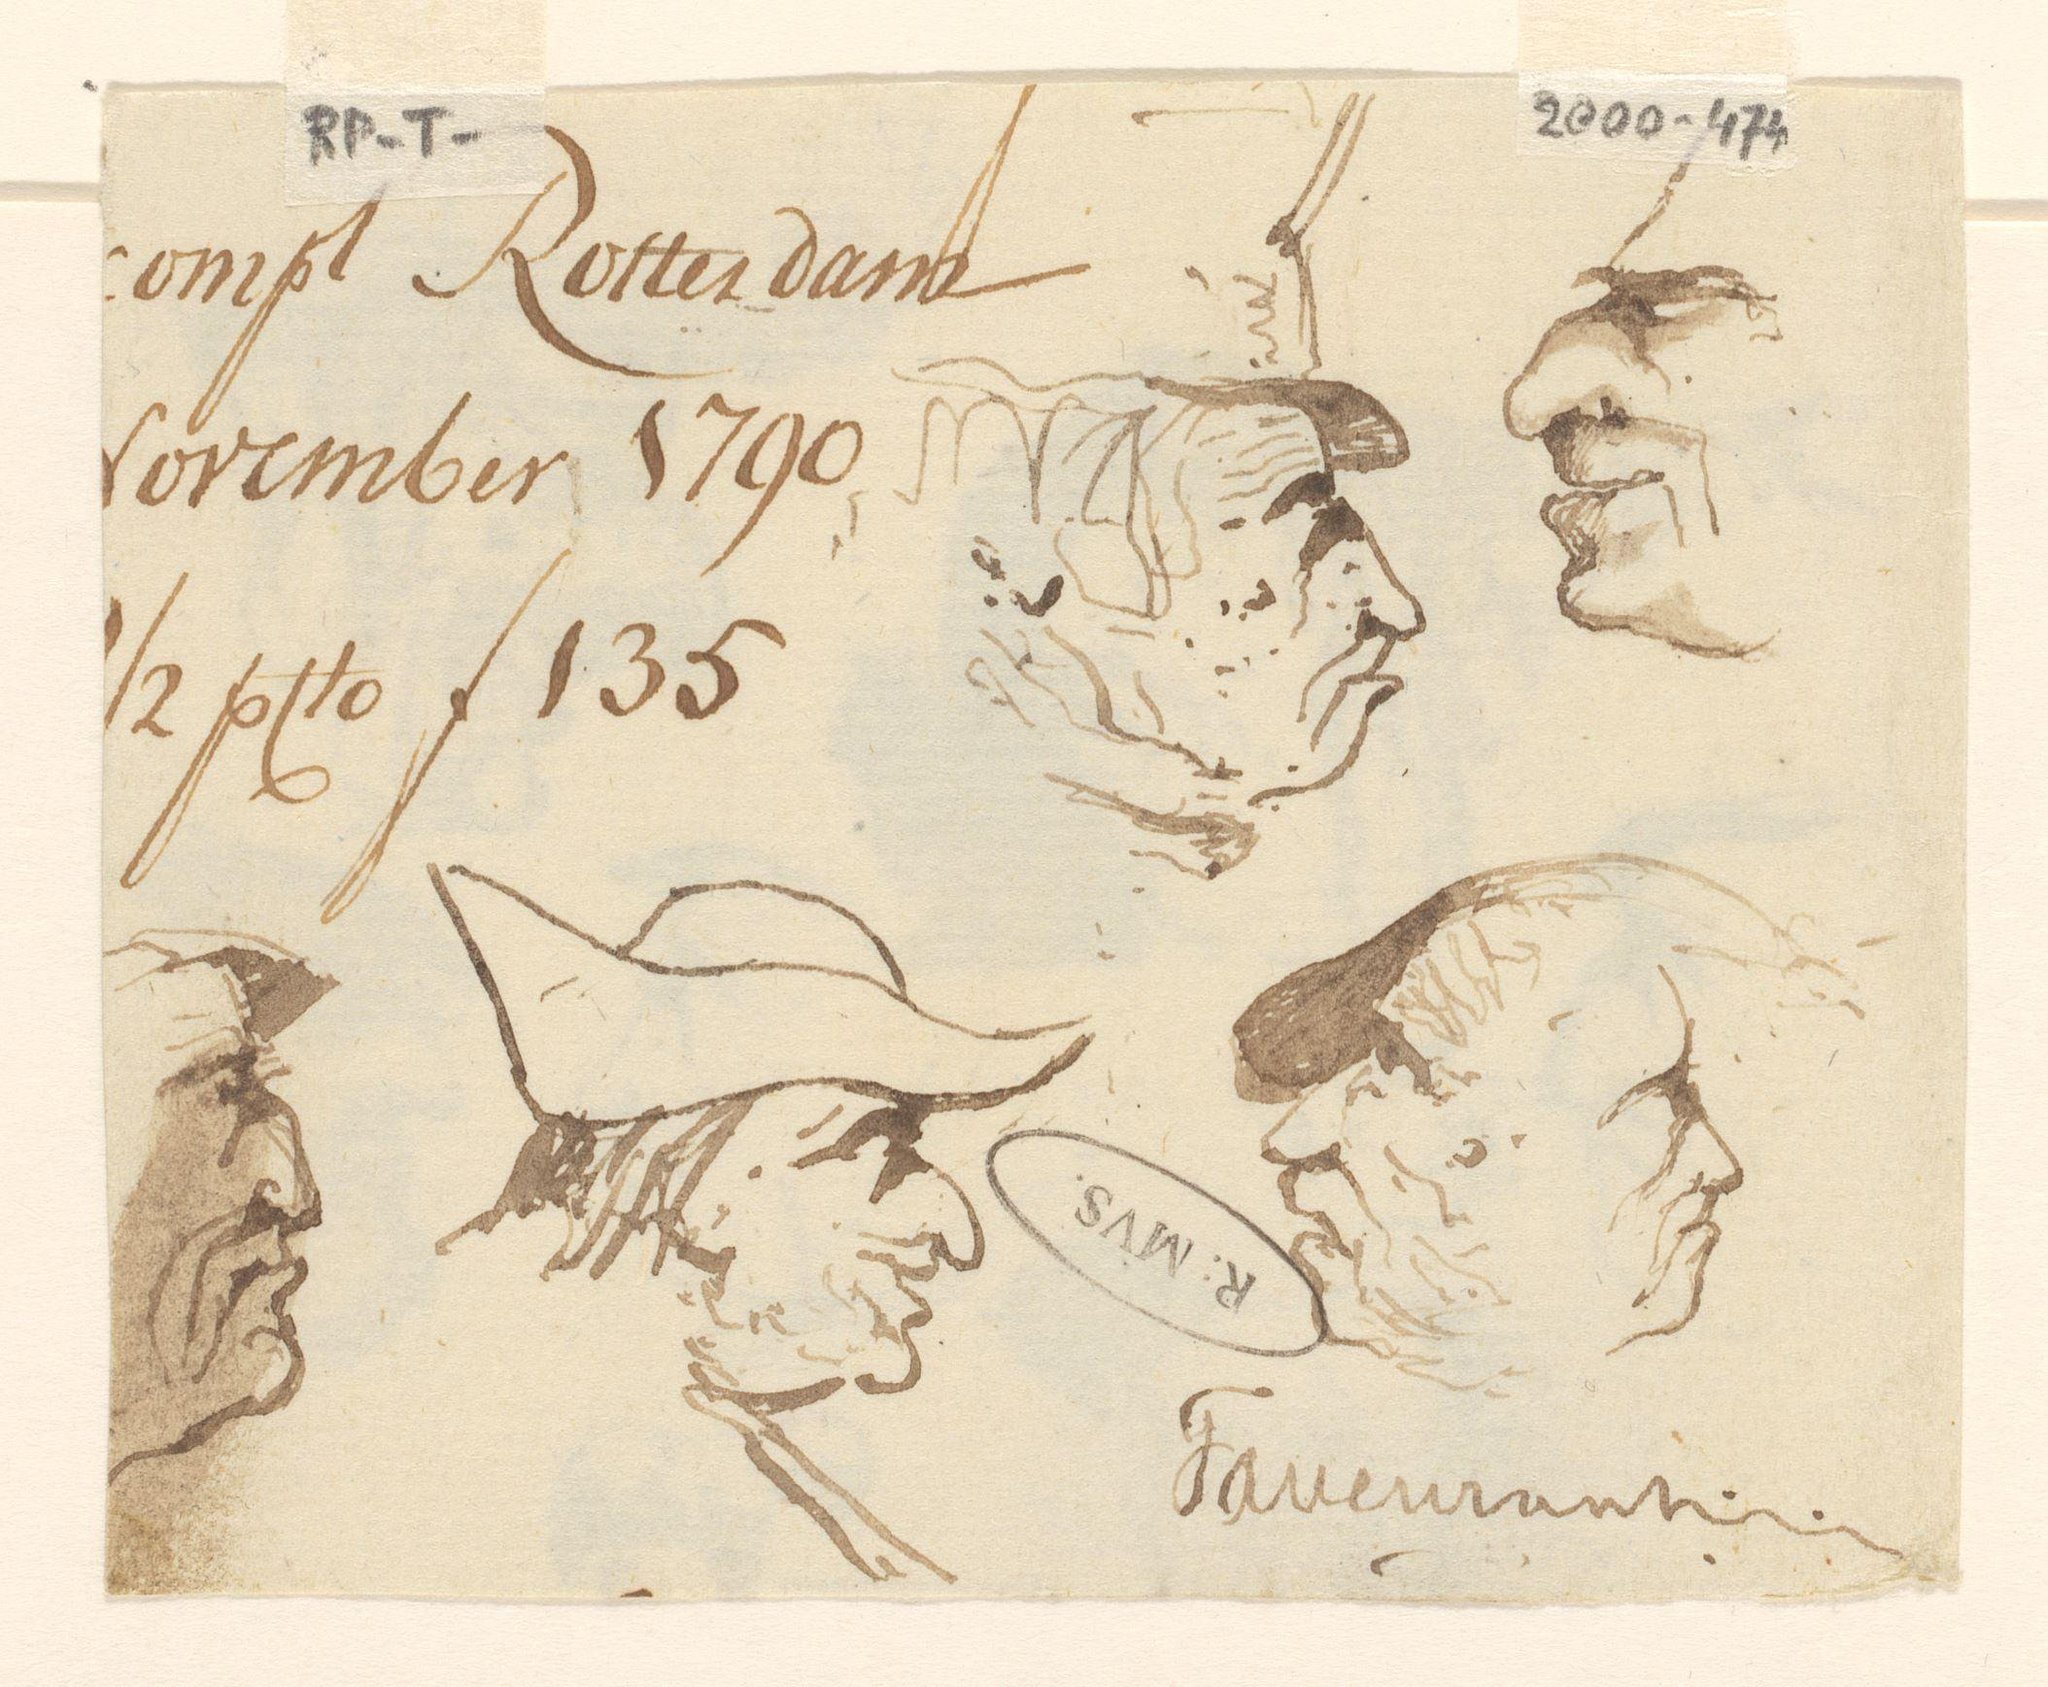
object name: drawing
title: Koppen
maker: johannes tavenraat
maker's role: draughtsman, painter, print maker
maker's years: 1809-1881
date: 1840-1880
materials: ink, paper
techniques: pen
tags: caricatures (human types)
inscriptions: collector's mark: Lugt 2228